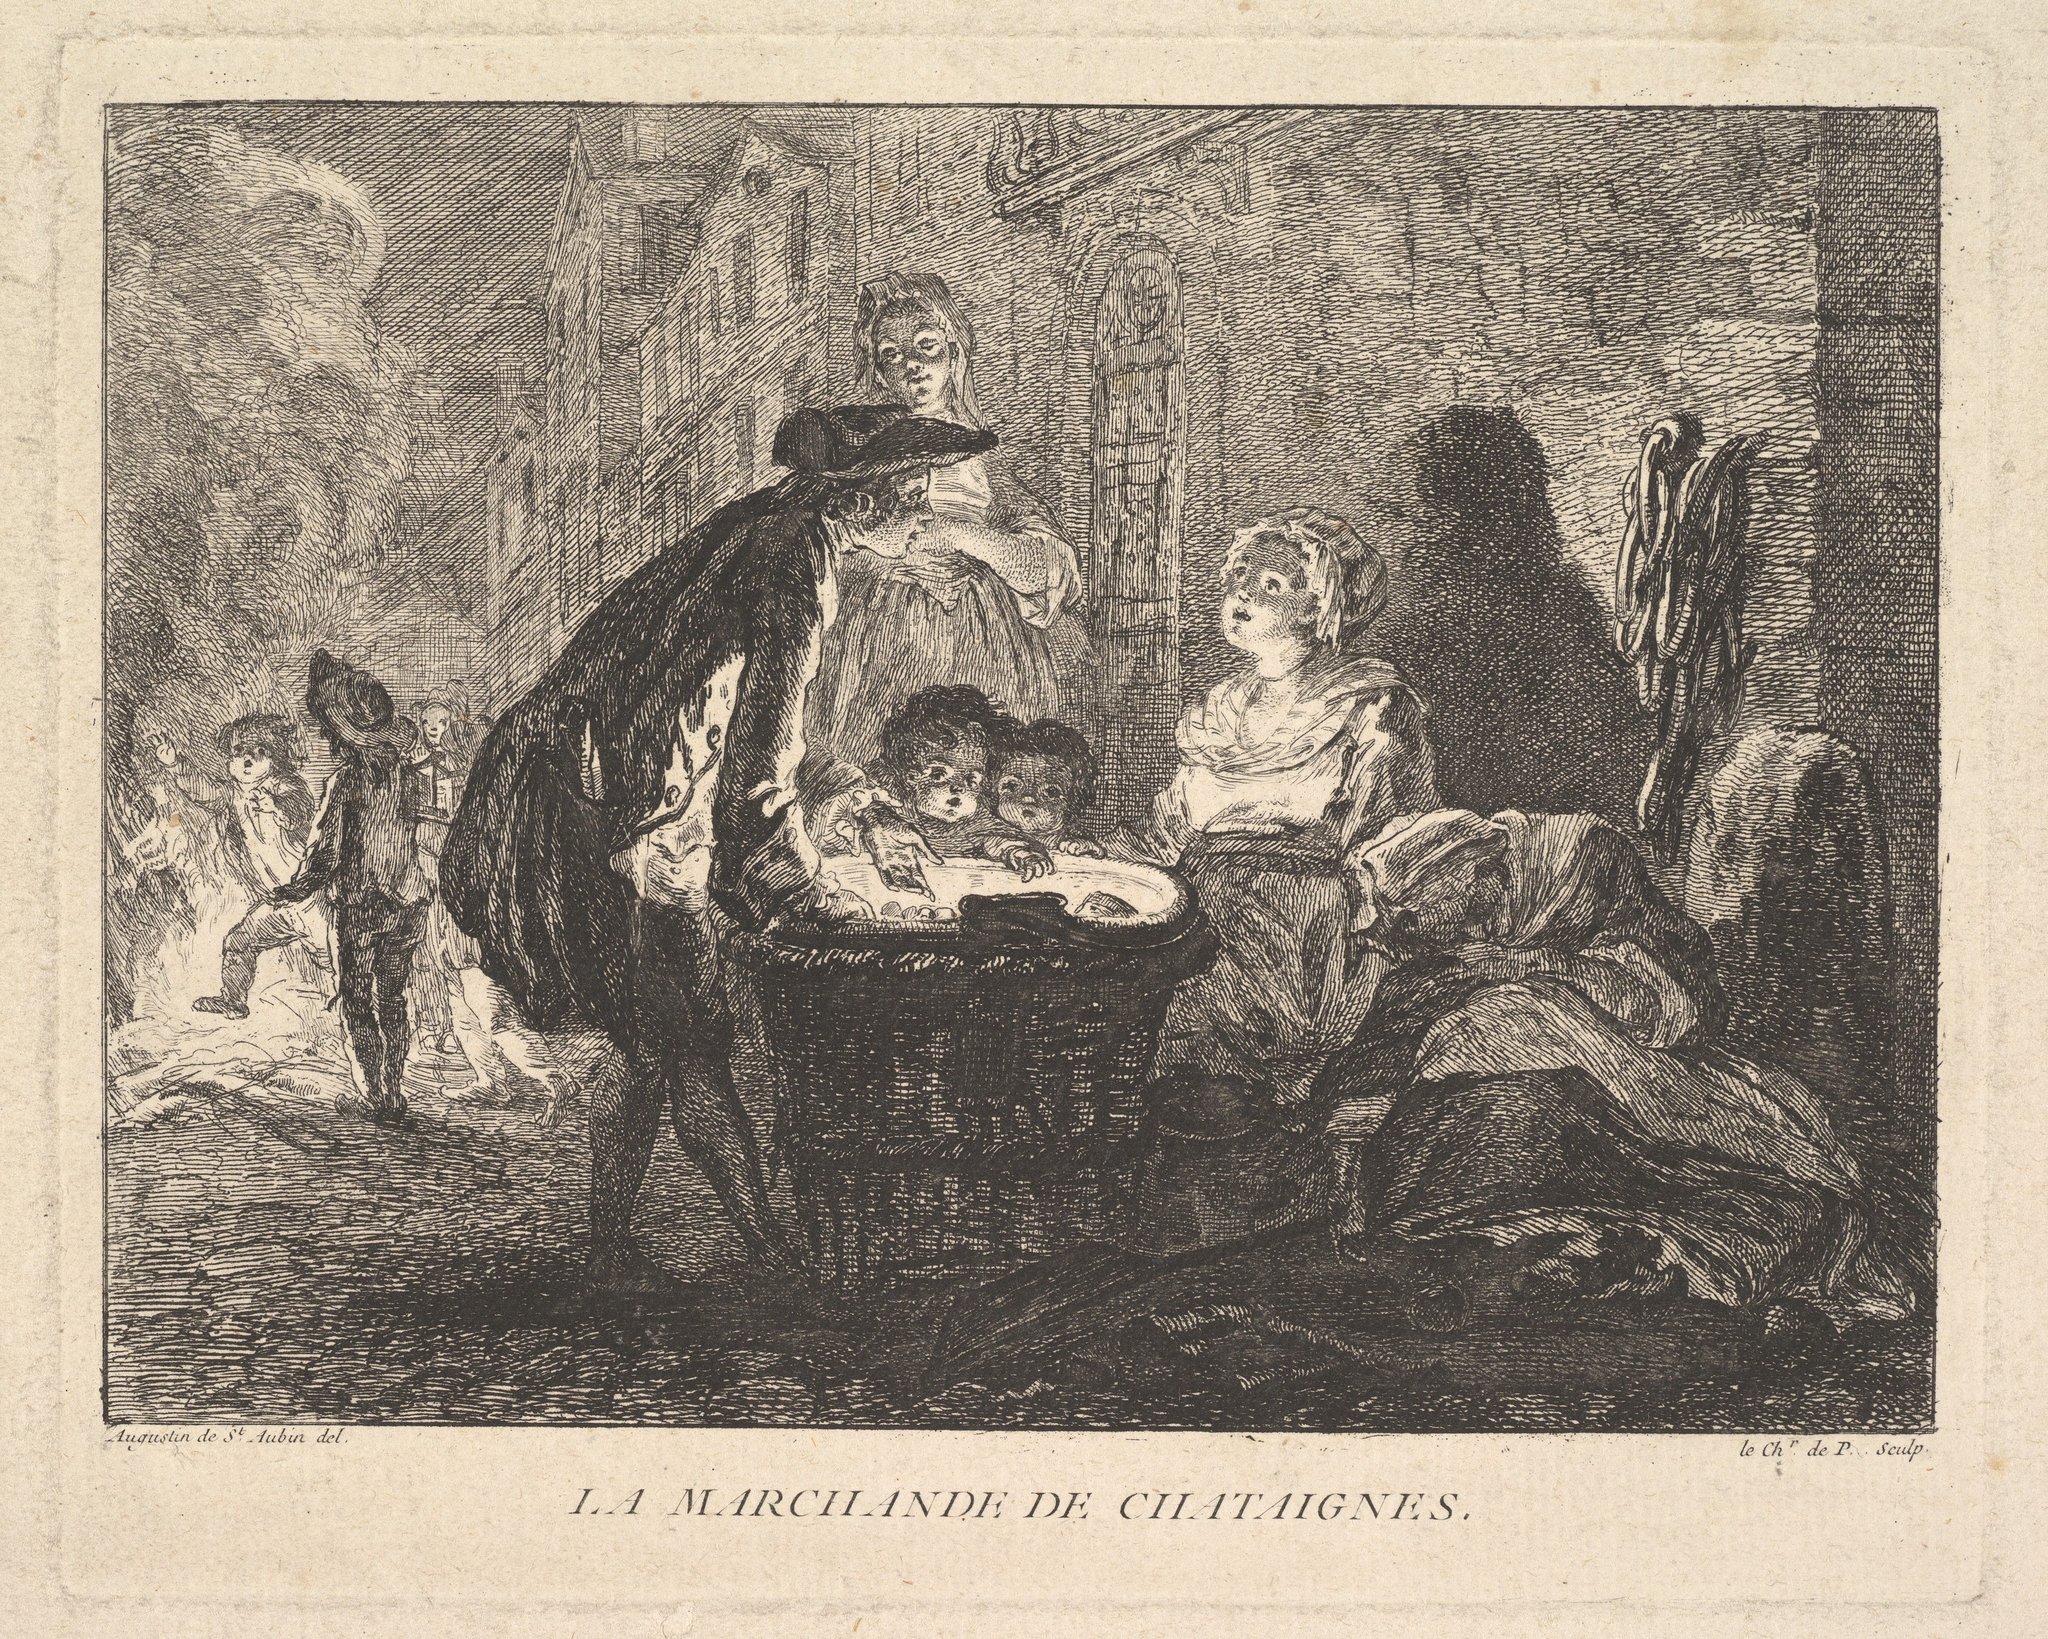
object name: print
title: The Chestnut Seller (La Marchande de Chataignes)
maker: chevalier de parlington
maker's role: artist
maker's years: 1750-1799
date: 1762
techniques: etching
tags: food,men,women